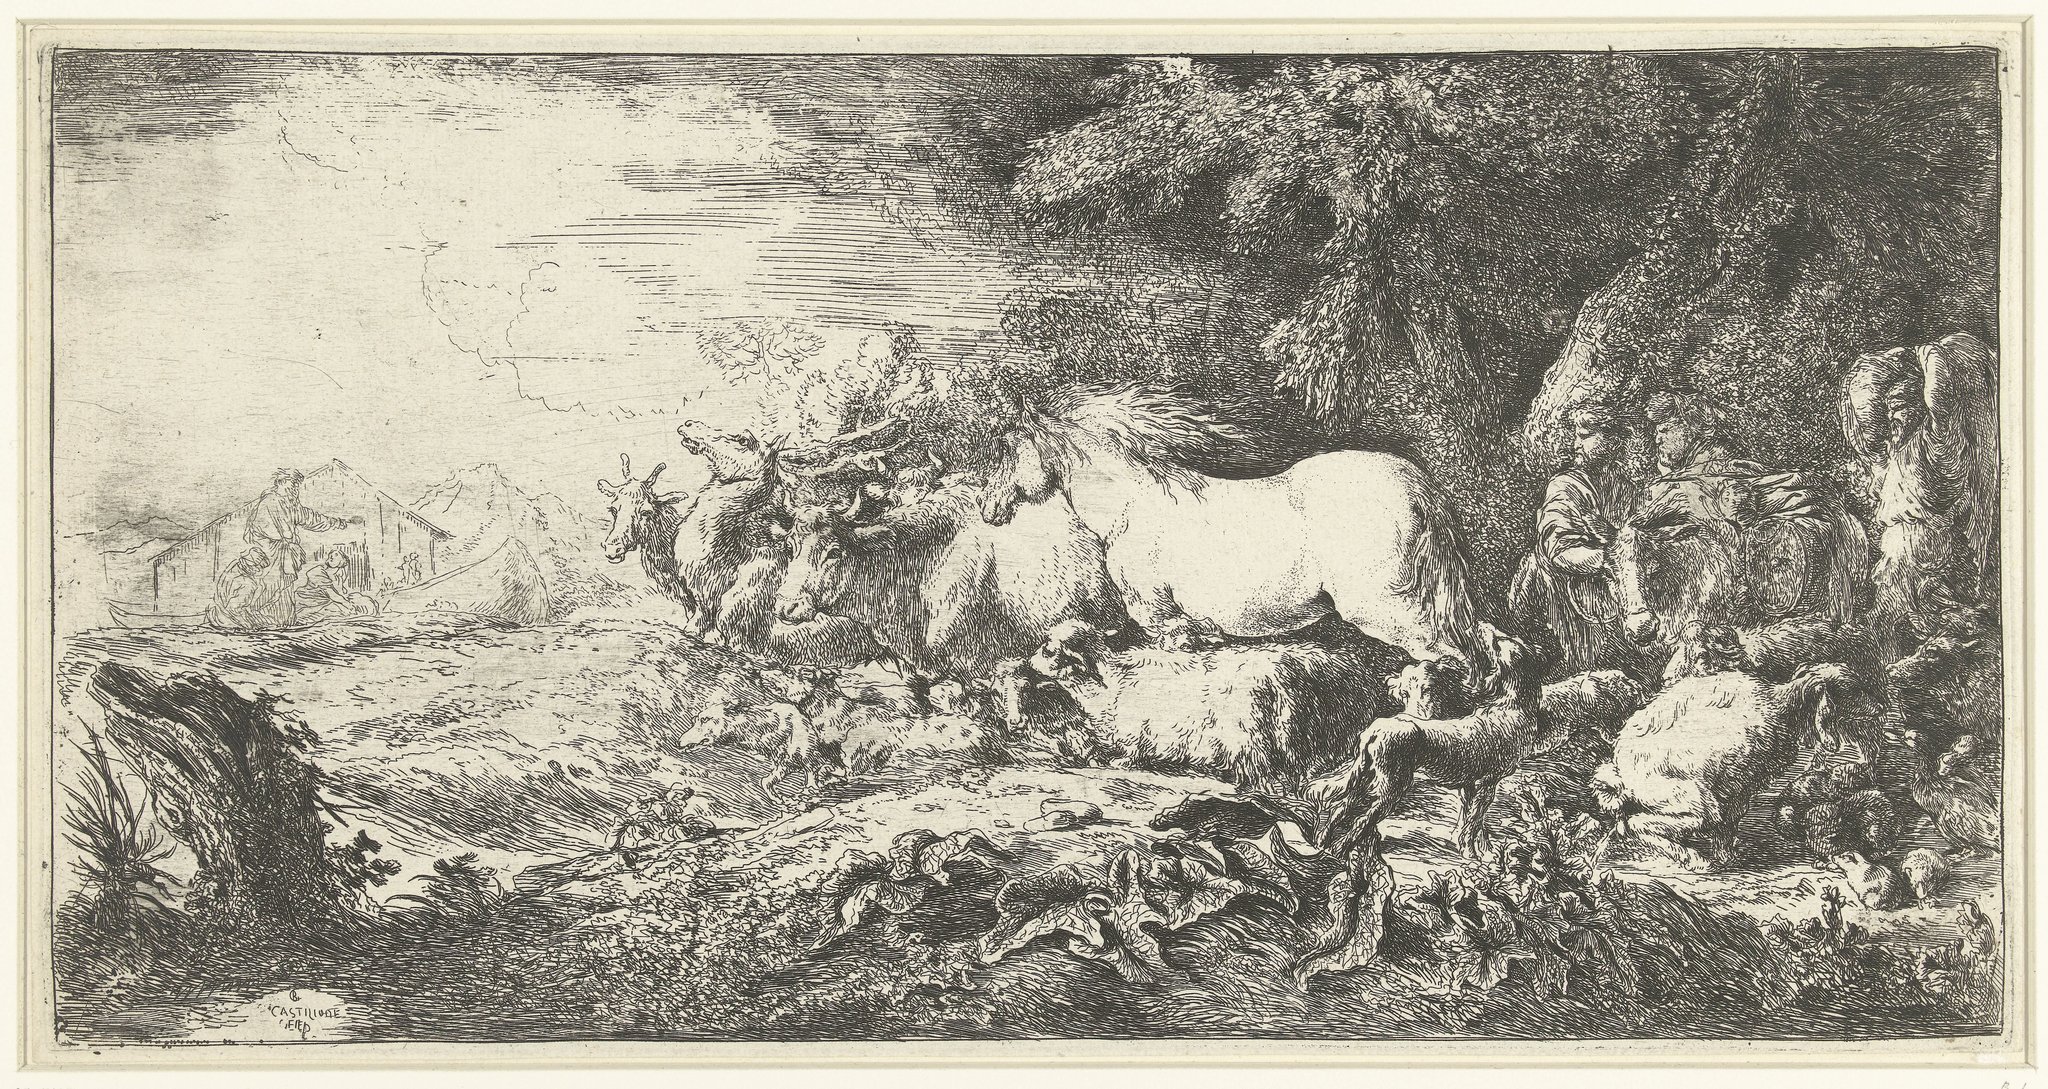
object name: print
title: Ark van Noach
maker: giovanni benedetto castiglione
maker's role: draughtsman, print maker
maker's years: 1610-1665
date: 1650-1655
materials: paper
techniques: etching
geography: rome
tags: the gathering of the animals in pairs ~ story of noah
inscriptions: collector's mark: Lugt 240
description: Drie mannen met een ezel en een grote groep dieren bij een bosrand. Zij bewegen zich richting de ark, waar Noach staat met zijn familie.